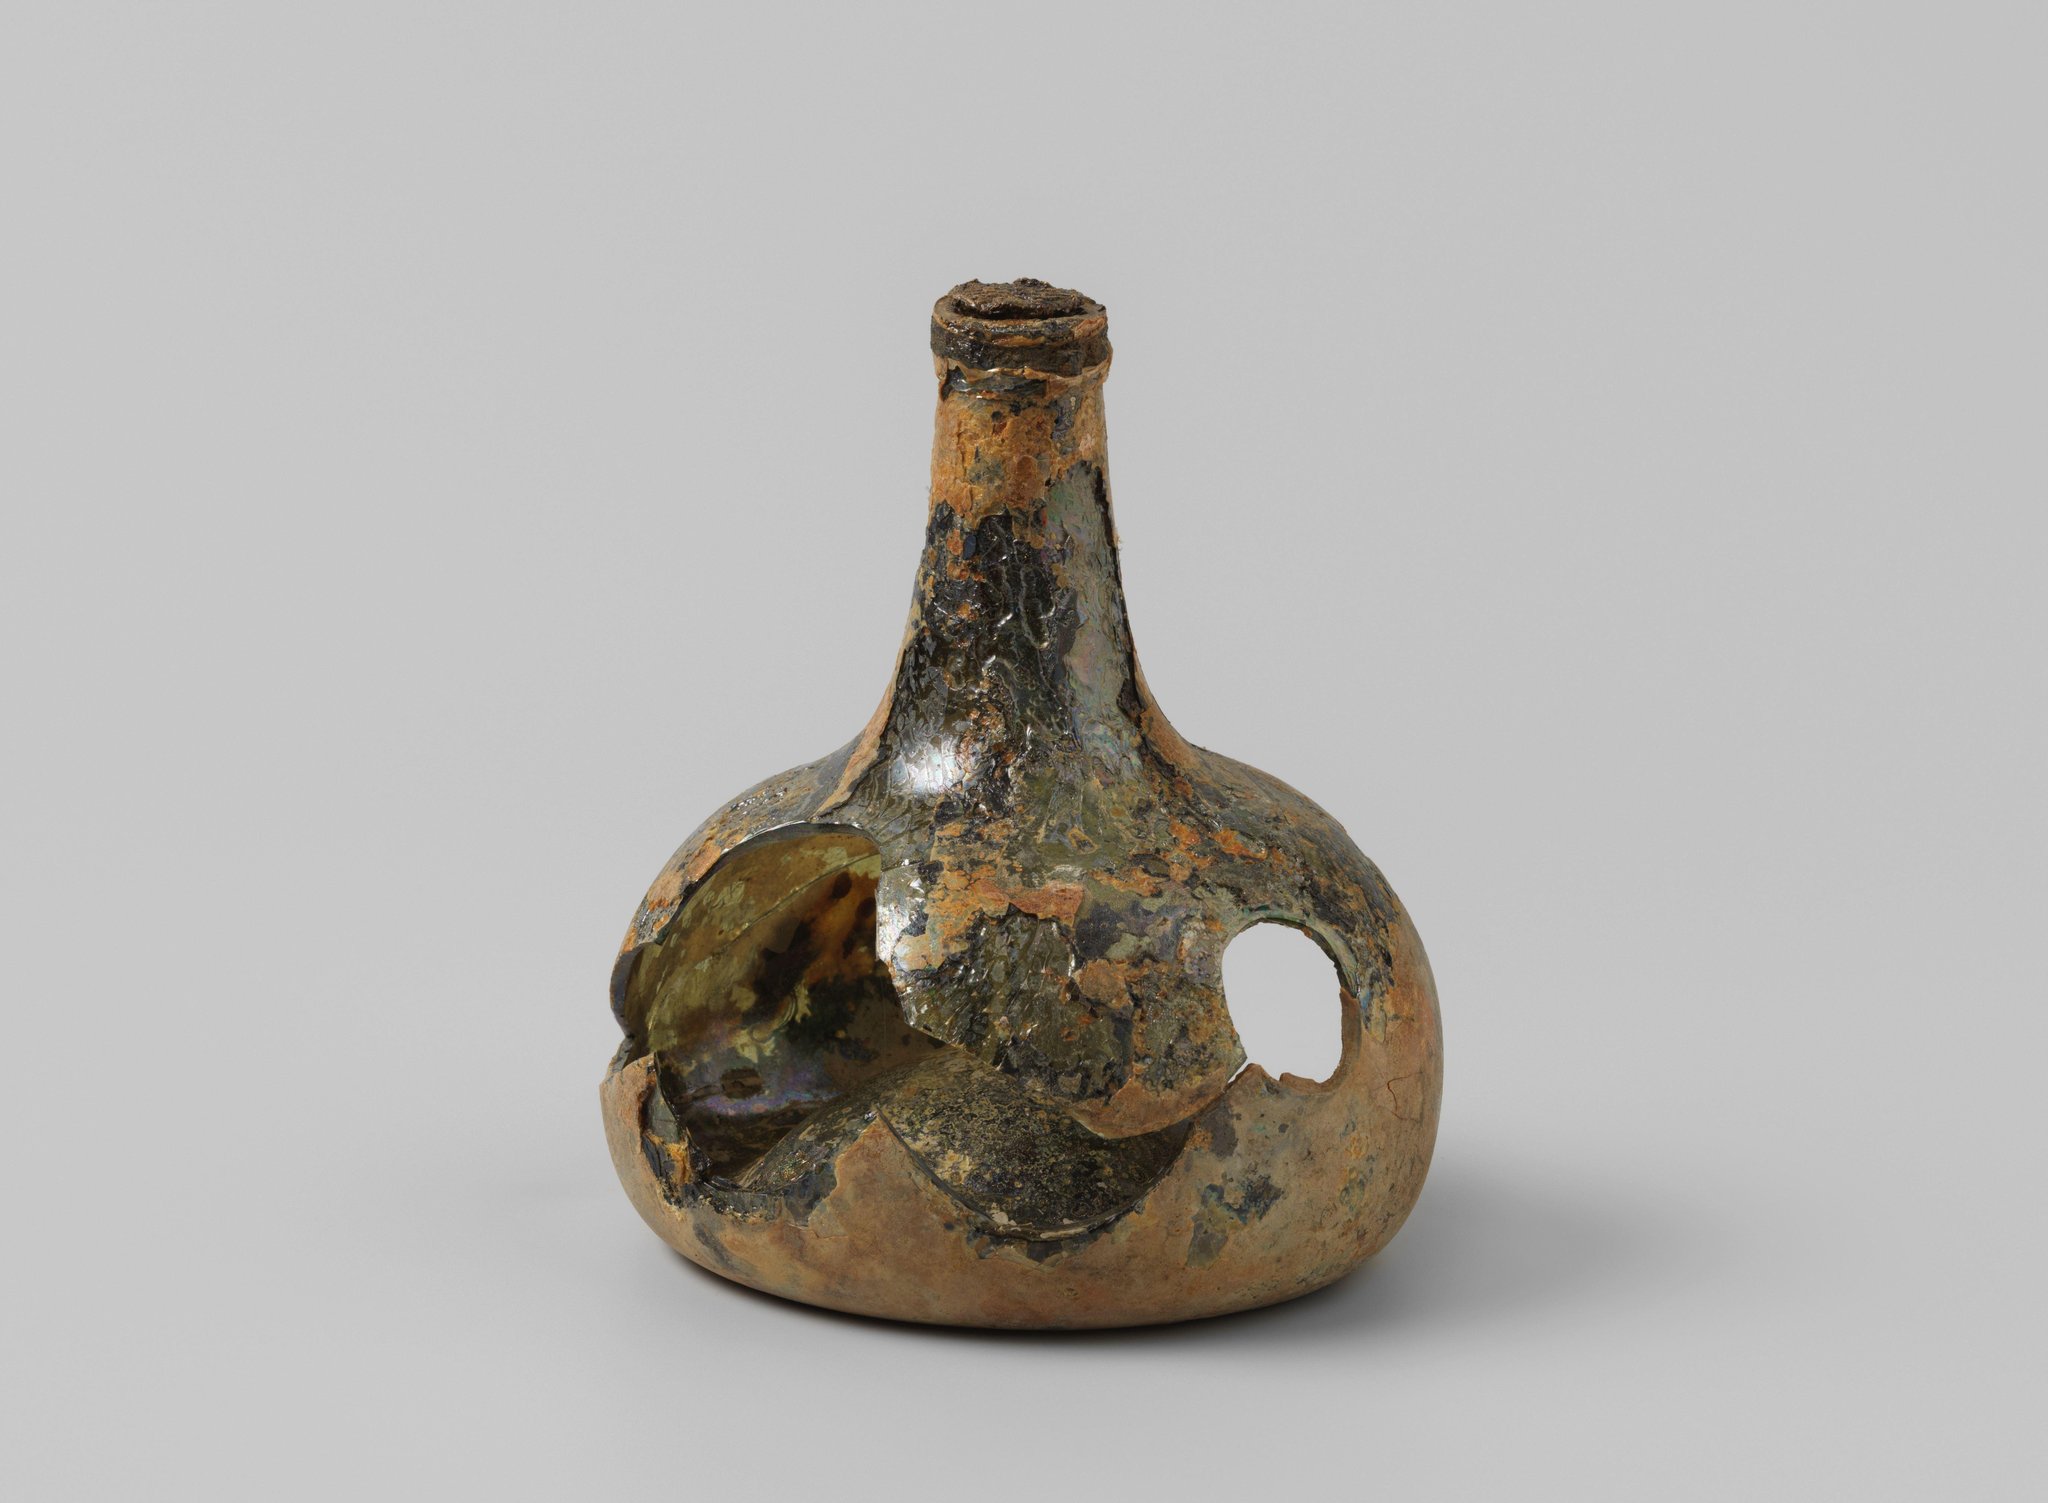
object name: wine bottle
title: Wijnfles uit het wrak van de Oostindiëvaarder 't Vliegend Hart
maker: Anonymous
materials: cork, glass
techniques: green glass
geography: netherlands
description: Uivormige wijnfles van glas. Twee grote fragmenten ontbreken en er zit een gat in. Kurk nog in de hals.